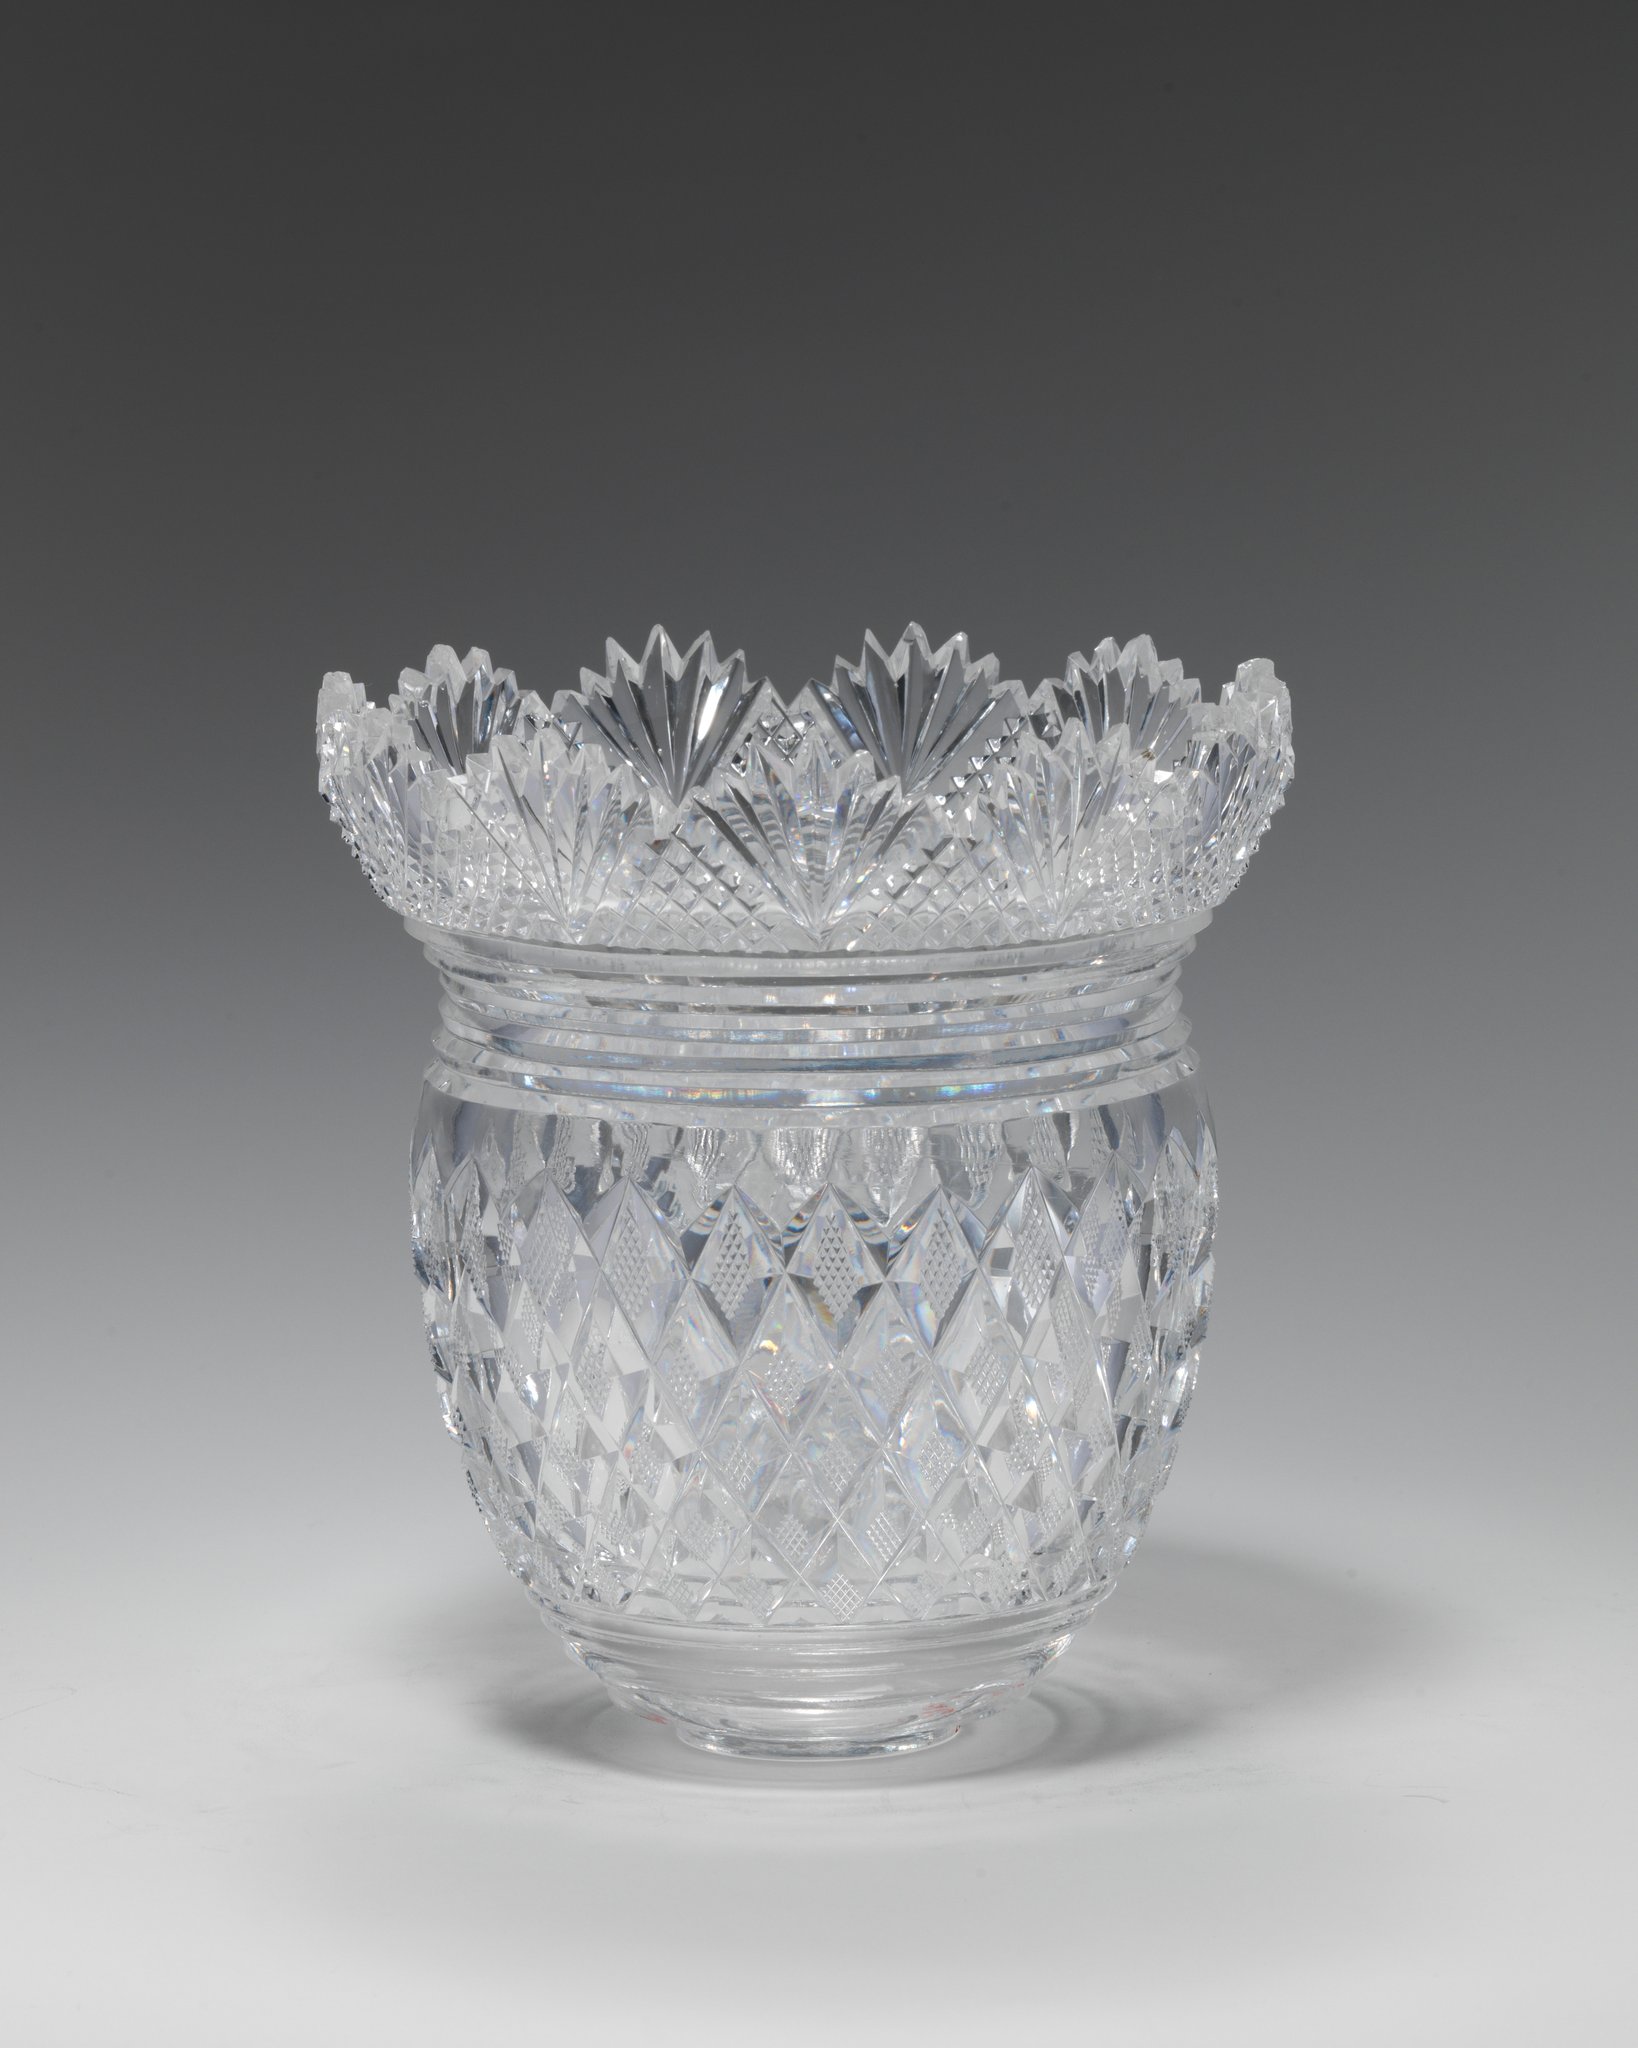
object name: jar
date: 1820-1830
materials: glass